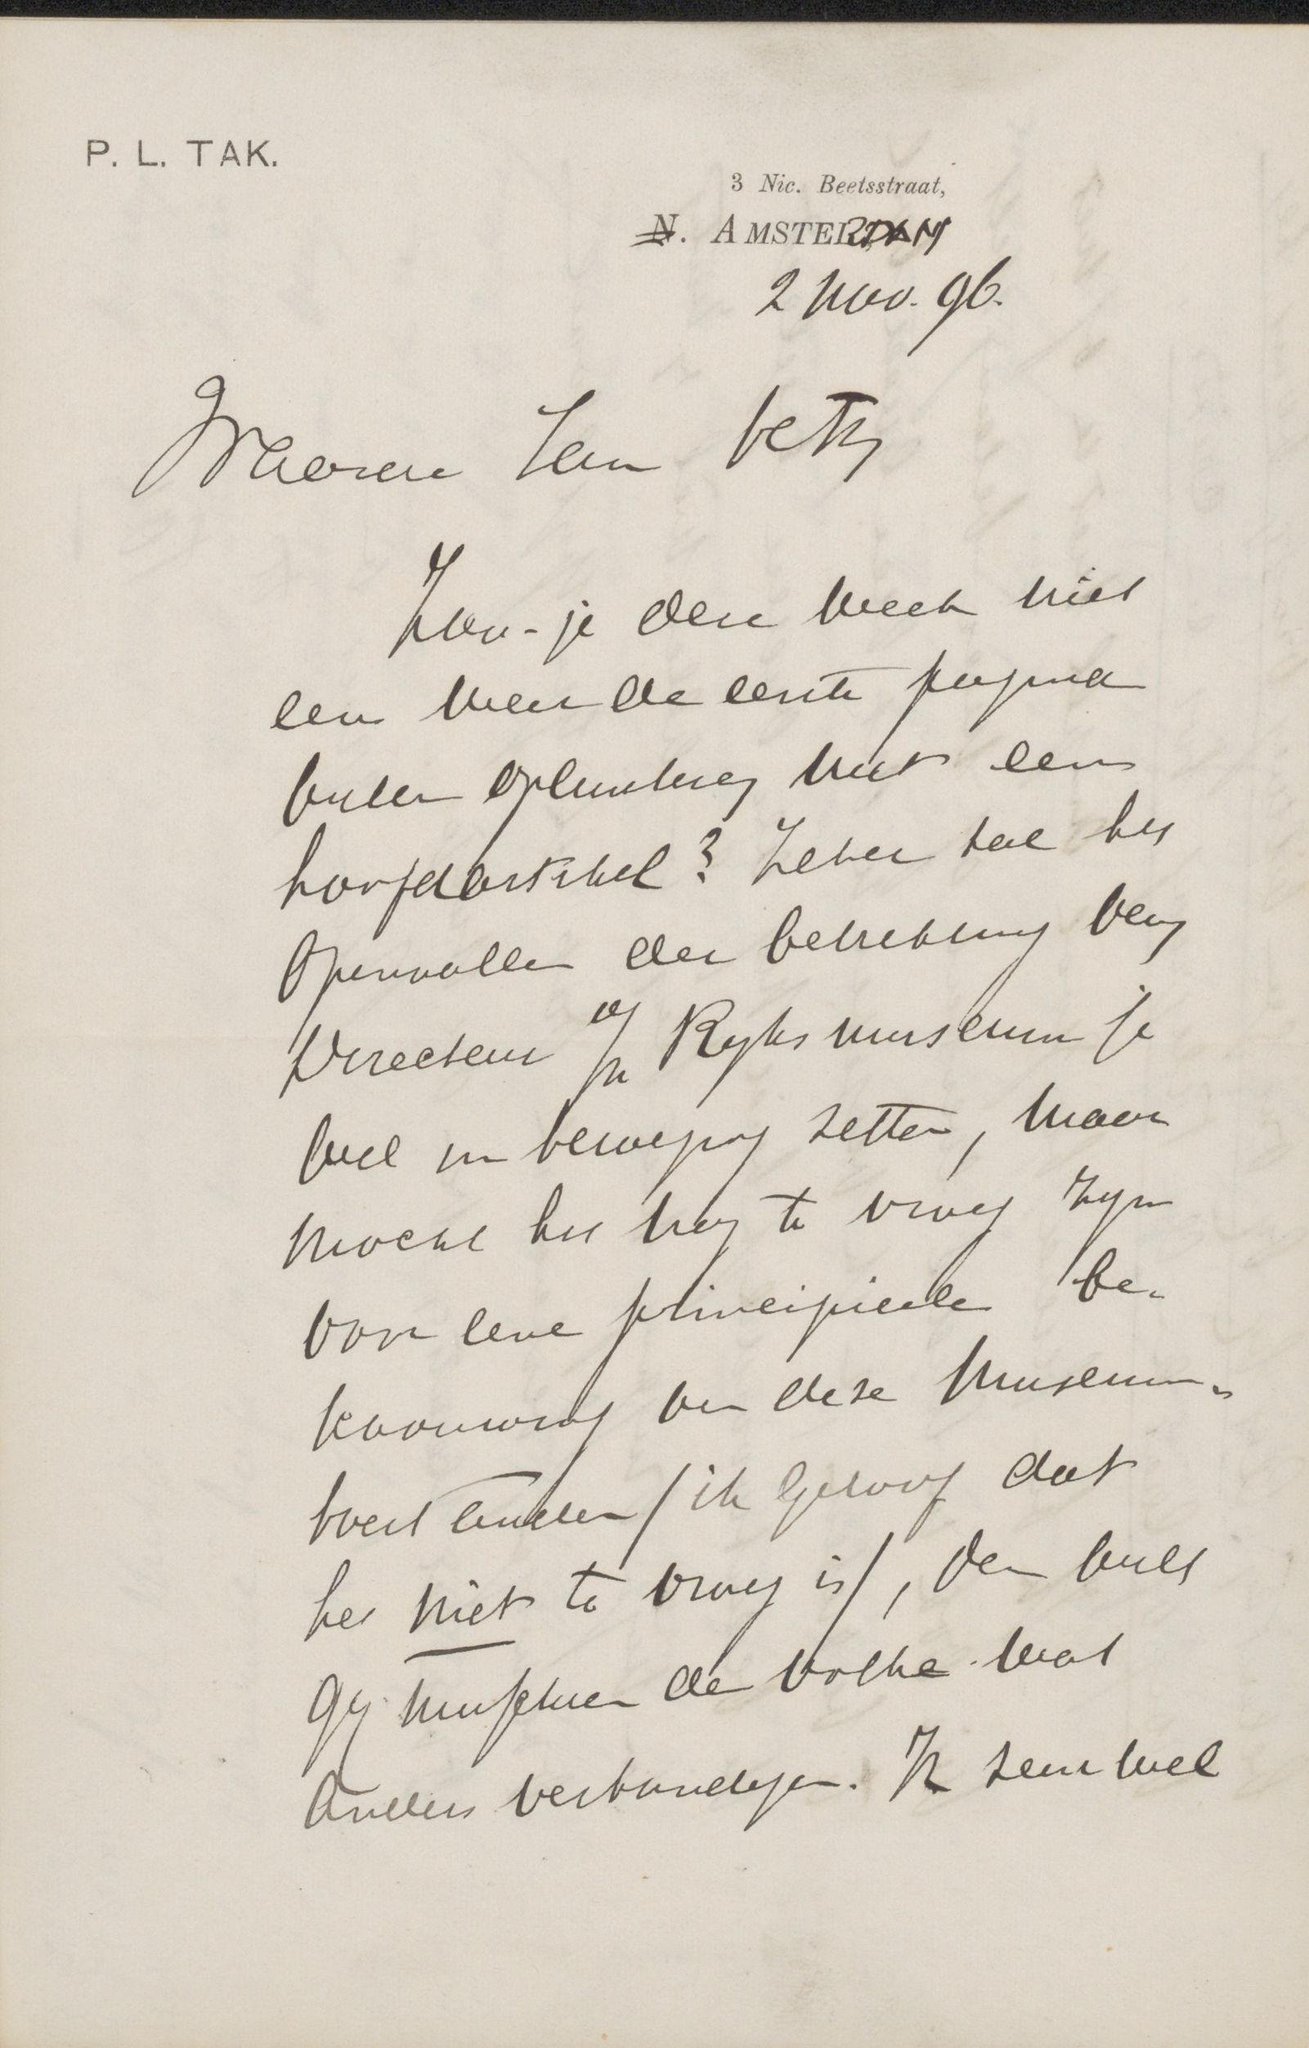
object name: letter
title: Brief aan Jan Veth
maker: pieter lodewijk tak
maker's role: politician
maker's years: 1848-1907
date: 1896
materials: ink, paper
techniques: pen, printing, writing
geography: amsterdam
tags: dordrecht, amsterdam, painter, print maker, draughtsman, designer, jan veth, liège, johannes de koo, andré jolles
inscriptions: watermark, collector's mark: ‘RPK’